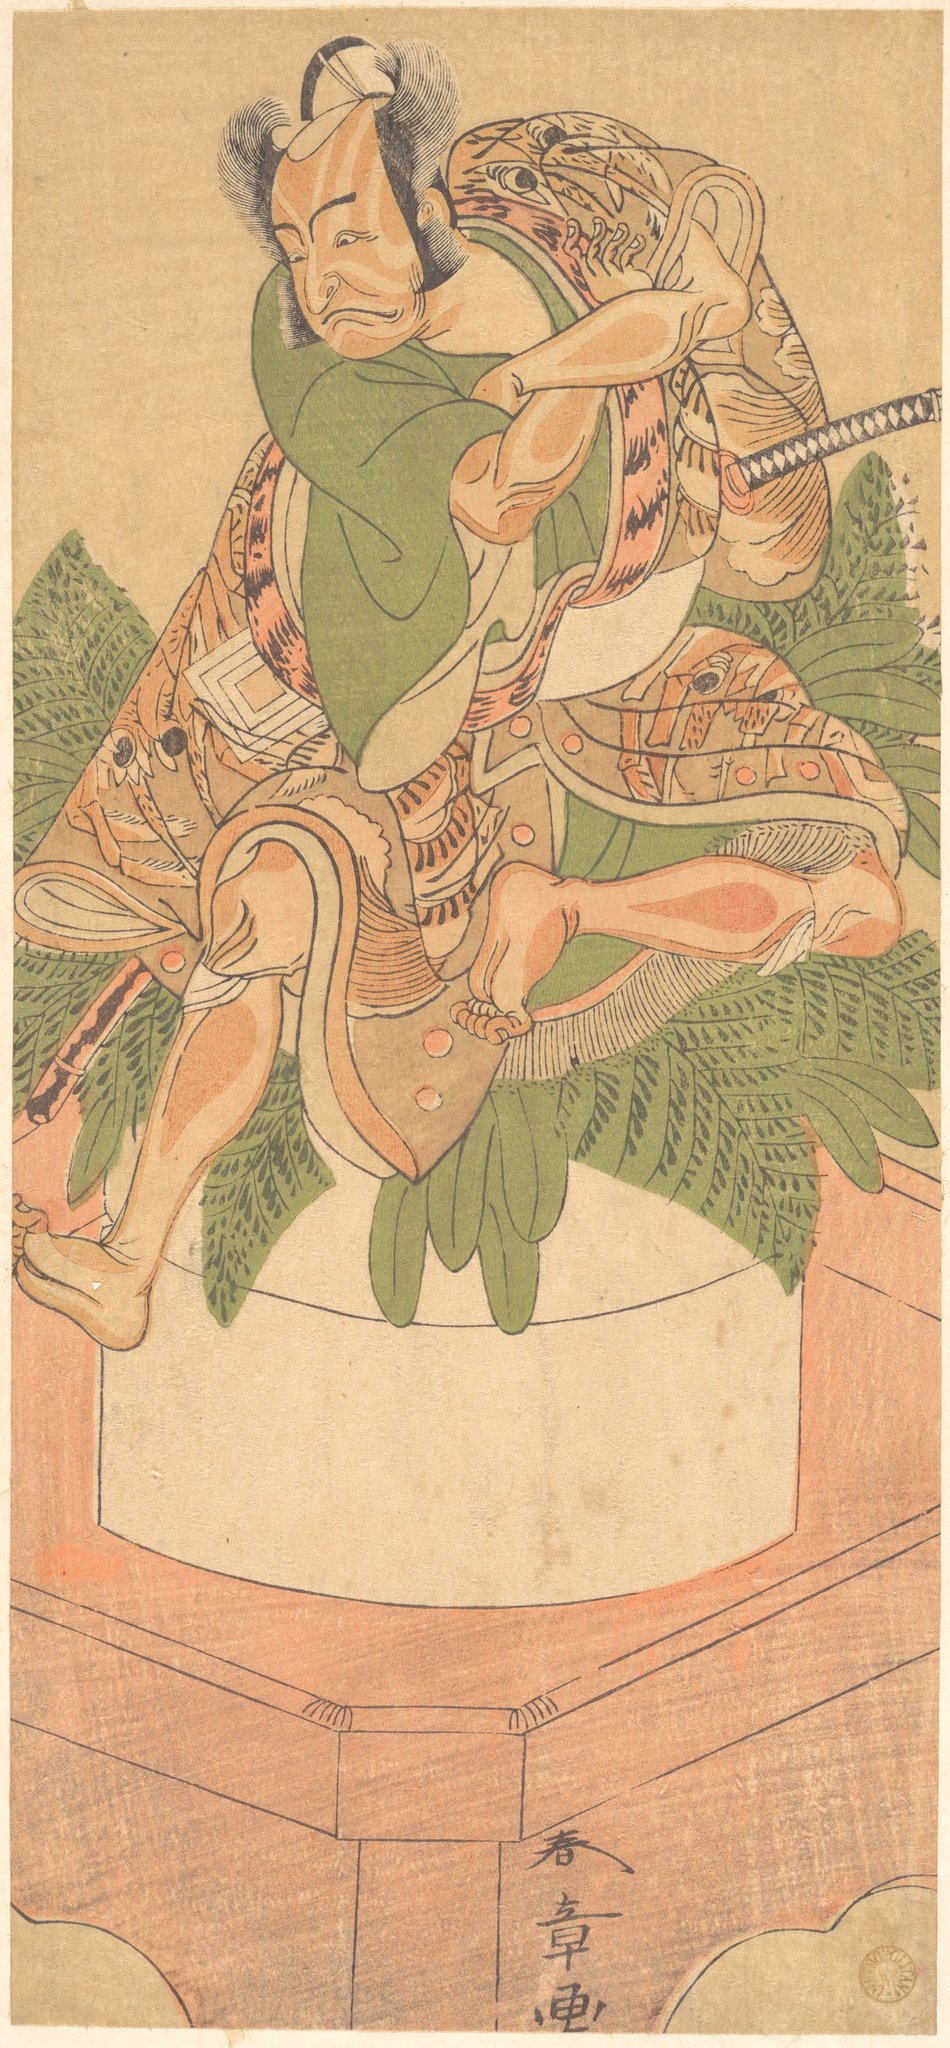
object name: woodblock print nishiki e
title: The Fourth Ichikawa Danjuro as a Yakko (servant) seated upon a Large Cake of Mochi Prepared for the New Yer Celebration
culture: japanese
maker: katsukawa shunshō 勝川春章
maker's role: artist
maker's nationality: japanese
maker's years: 1726-1792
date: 1772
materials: ink, paper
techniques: nishiki e, woodblock print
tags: men,actors